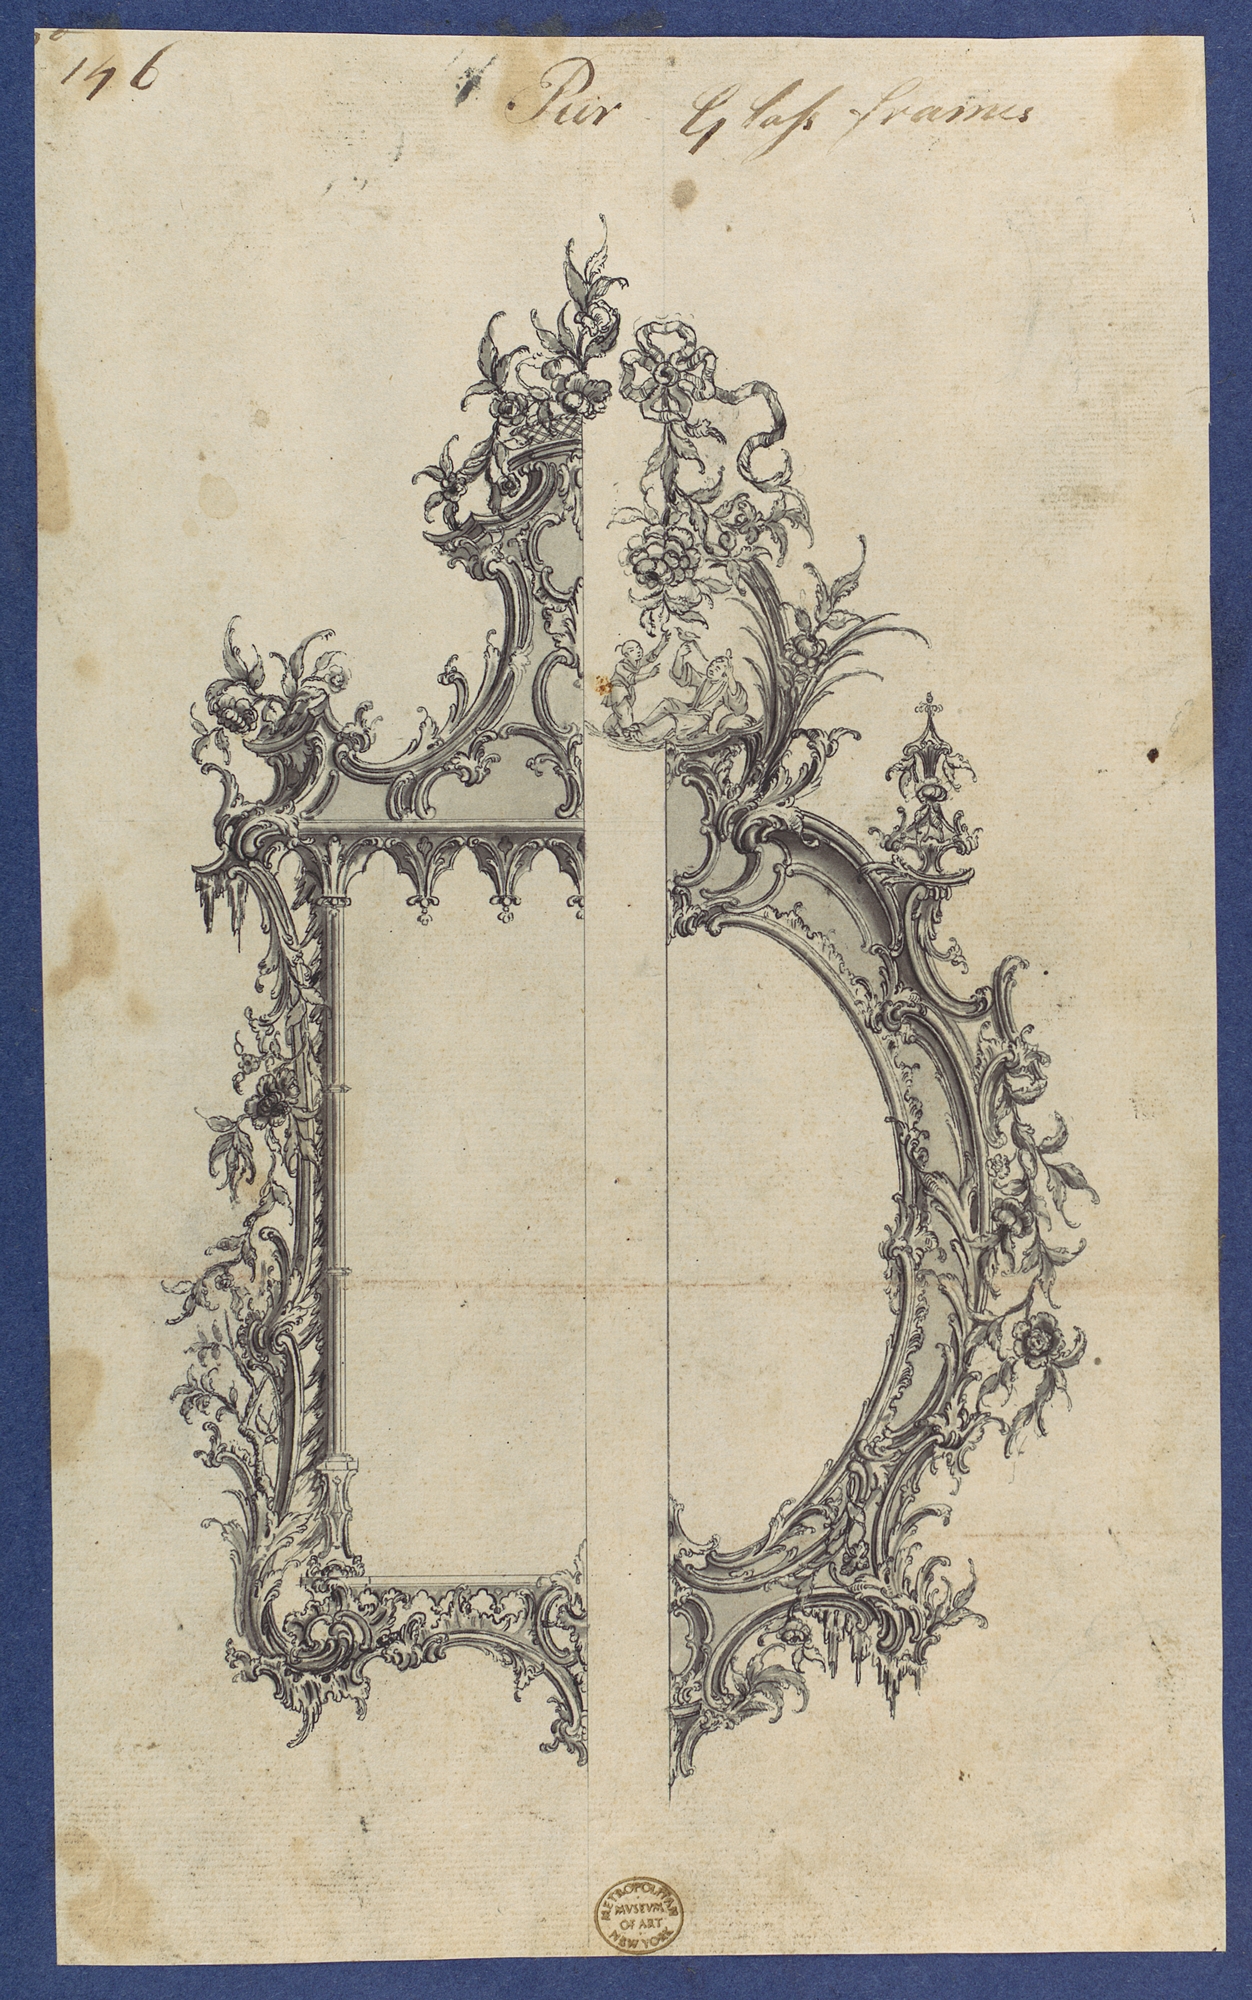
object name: drawing ornament architecture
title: Pier Glass Frames, in Chippendale Drawings, Vol. I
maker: thomas chippendale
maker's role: artist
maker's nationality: british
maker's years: 1718-1779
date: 1754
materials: ink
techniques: wash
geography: london